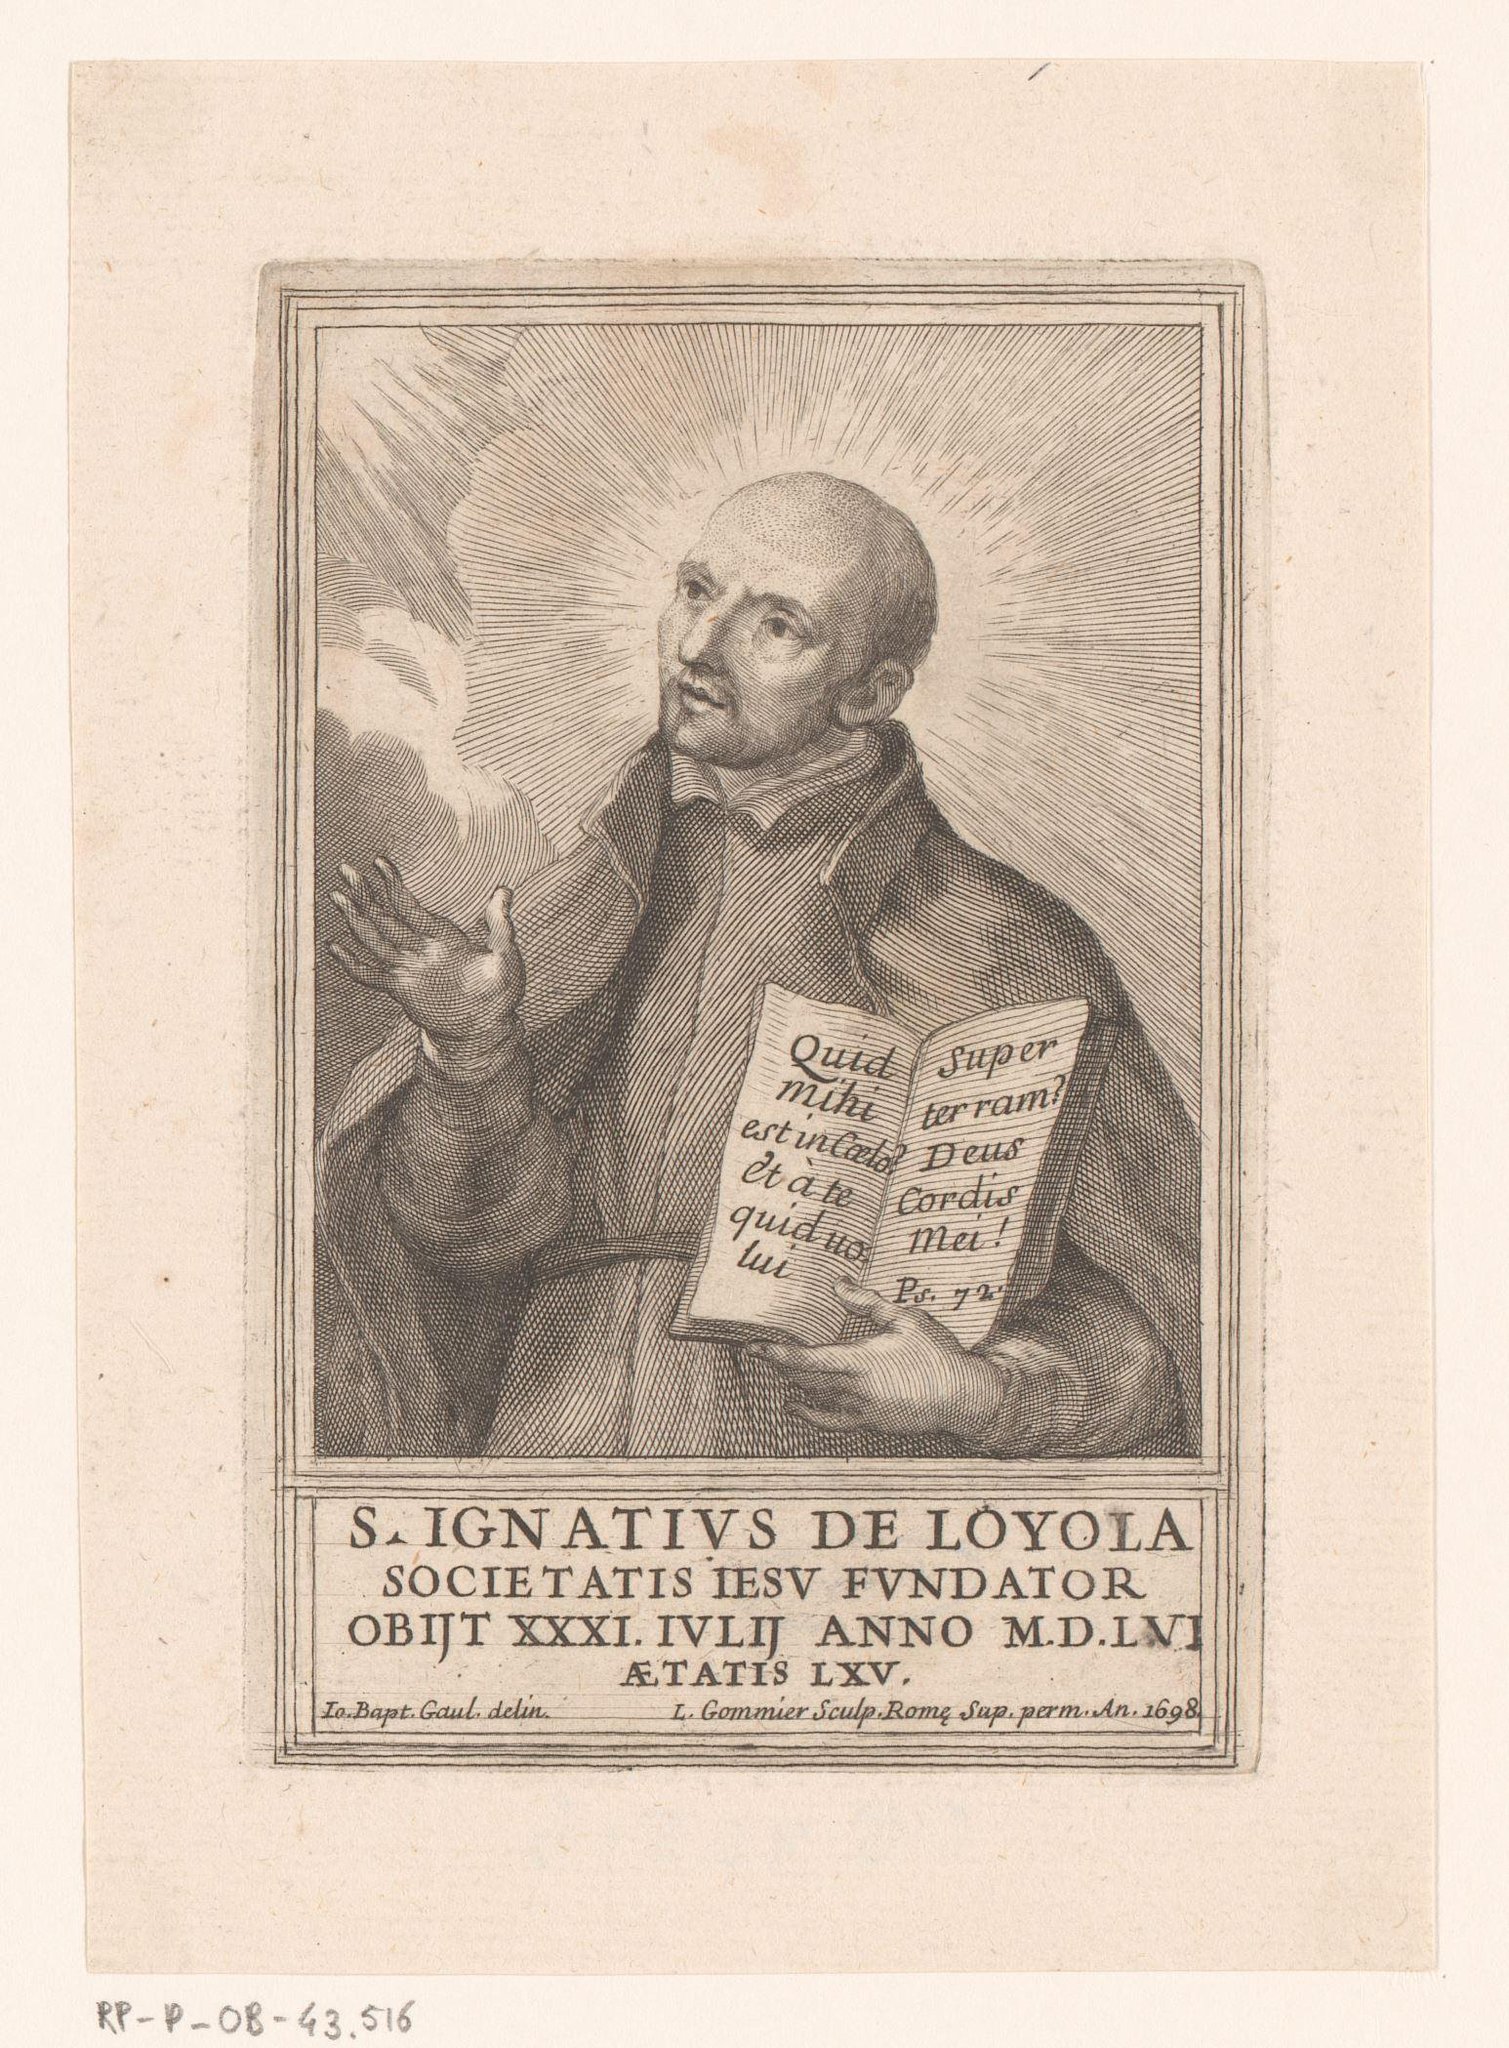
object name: print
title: Heilige Ignatius van Loyola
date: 1698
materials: paper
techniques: engraving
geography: rome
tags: the founder of the jesuit order, ignatius of loyola; possible attributes: book (with 'ad majorem dei gloriam'), demon, dragon under feet, flames, flaming heart, globe, ihs monogram, skull (with crown), tears in eyes, torch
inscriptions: collector's mark: Lugt 2228